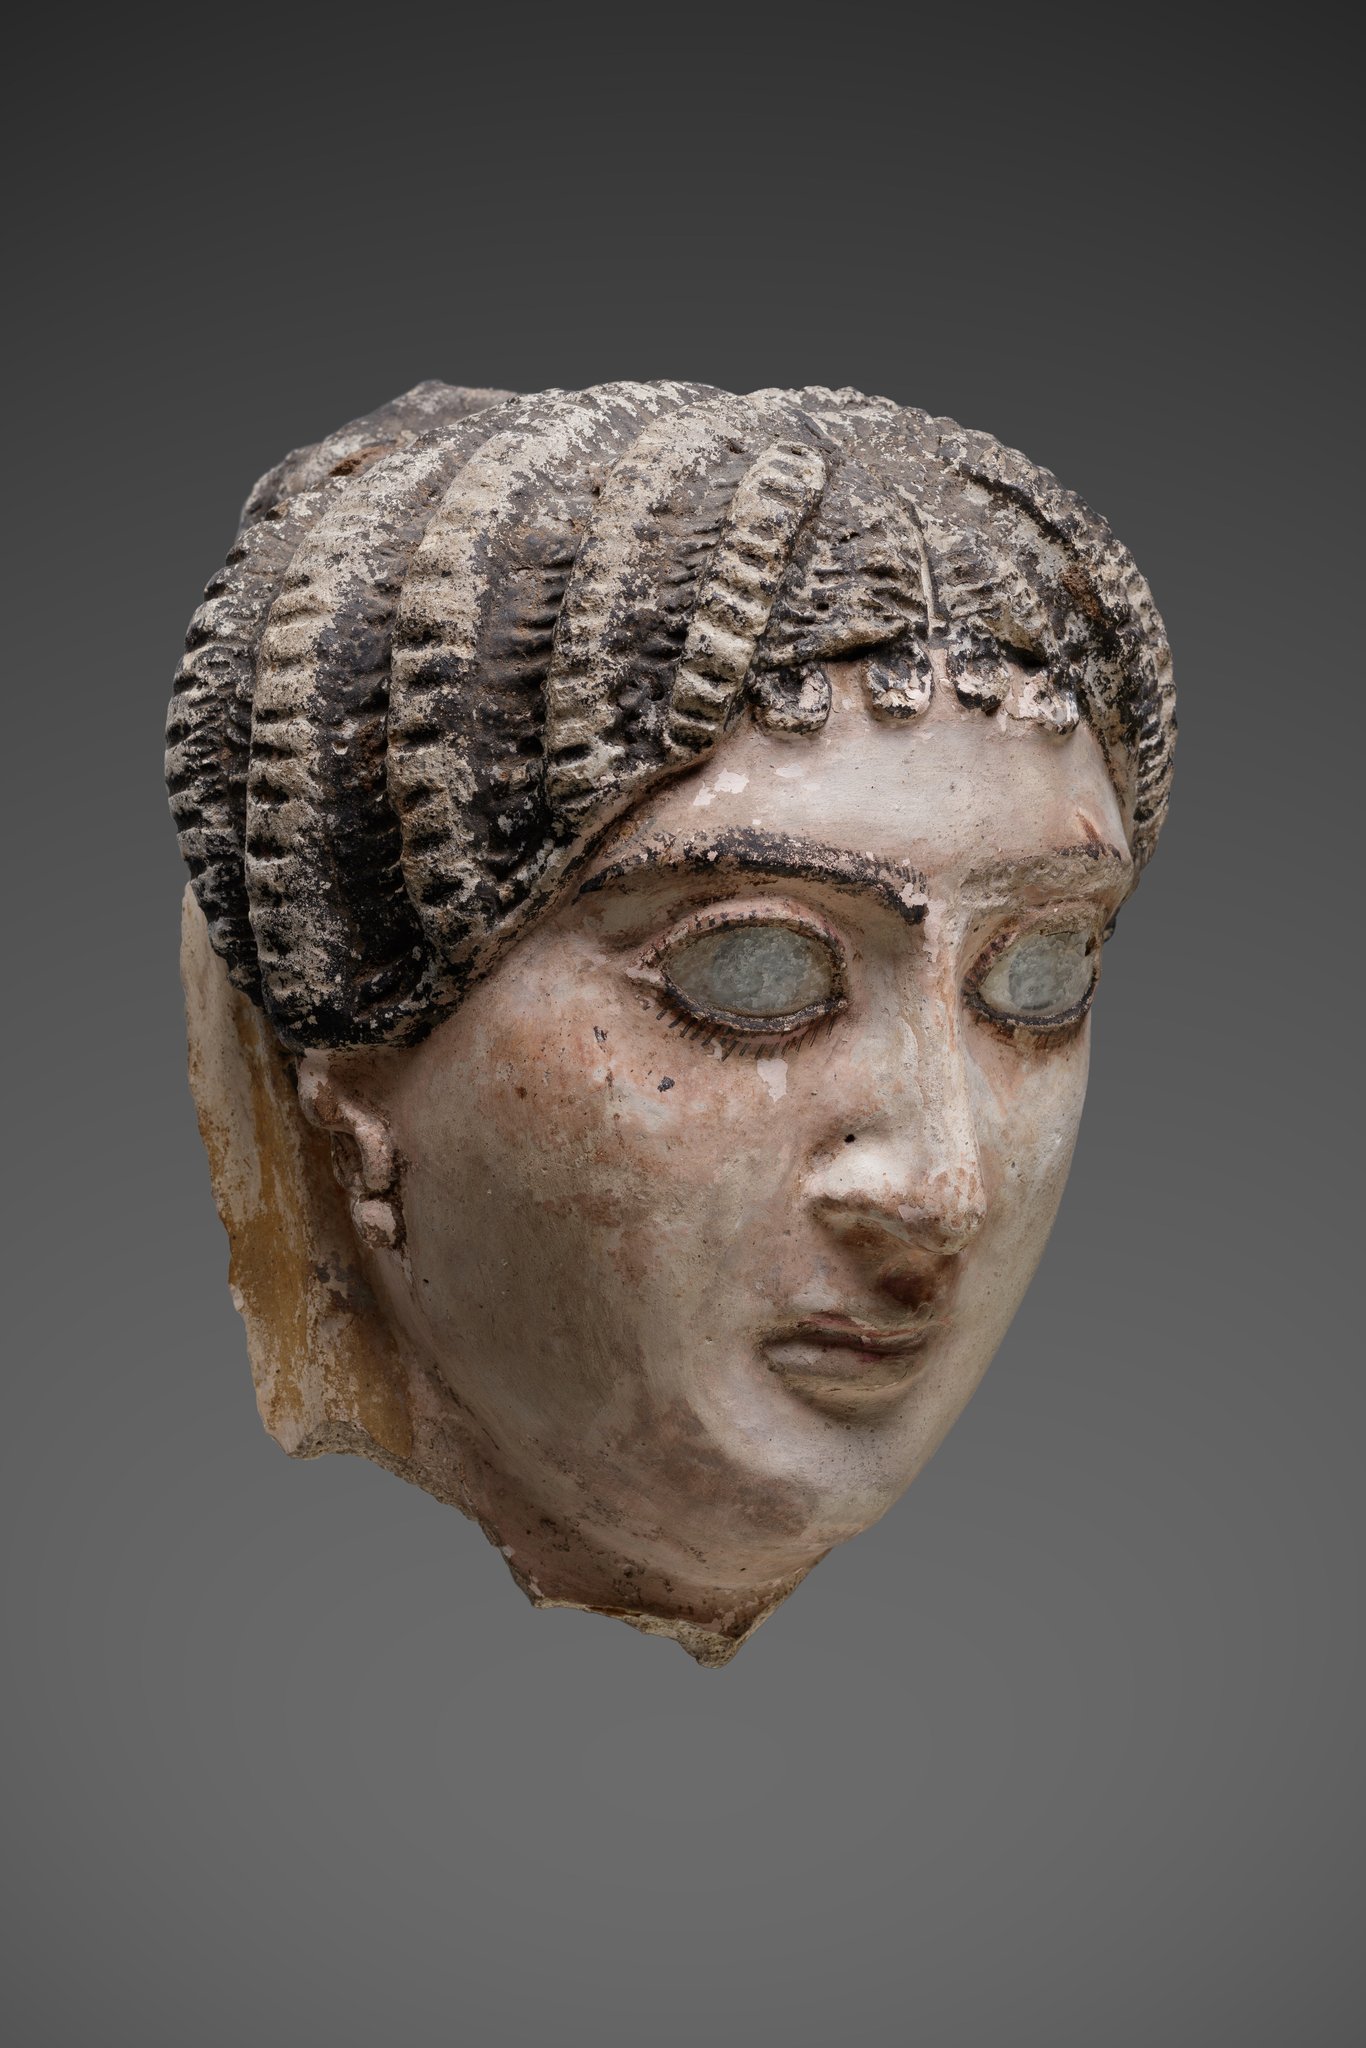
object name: mask, woman, radiating wave of hair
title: Mask of a woman with radiating waves of hair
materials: glass, paint, plaster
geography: egypt